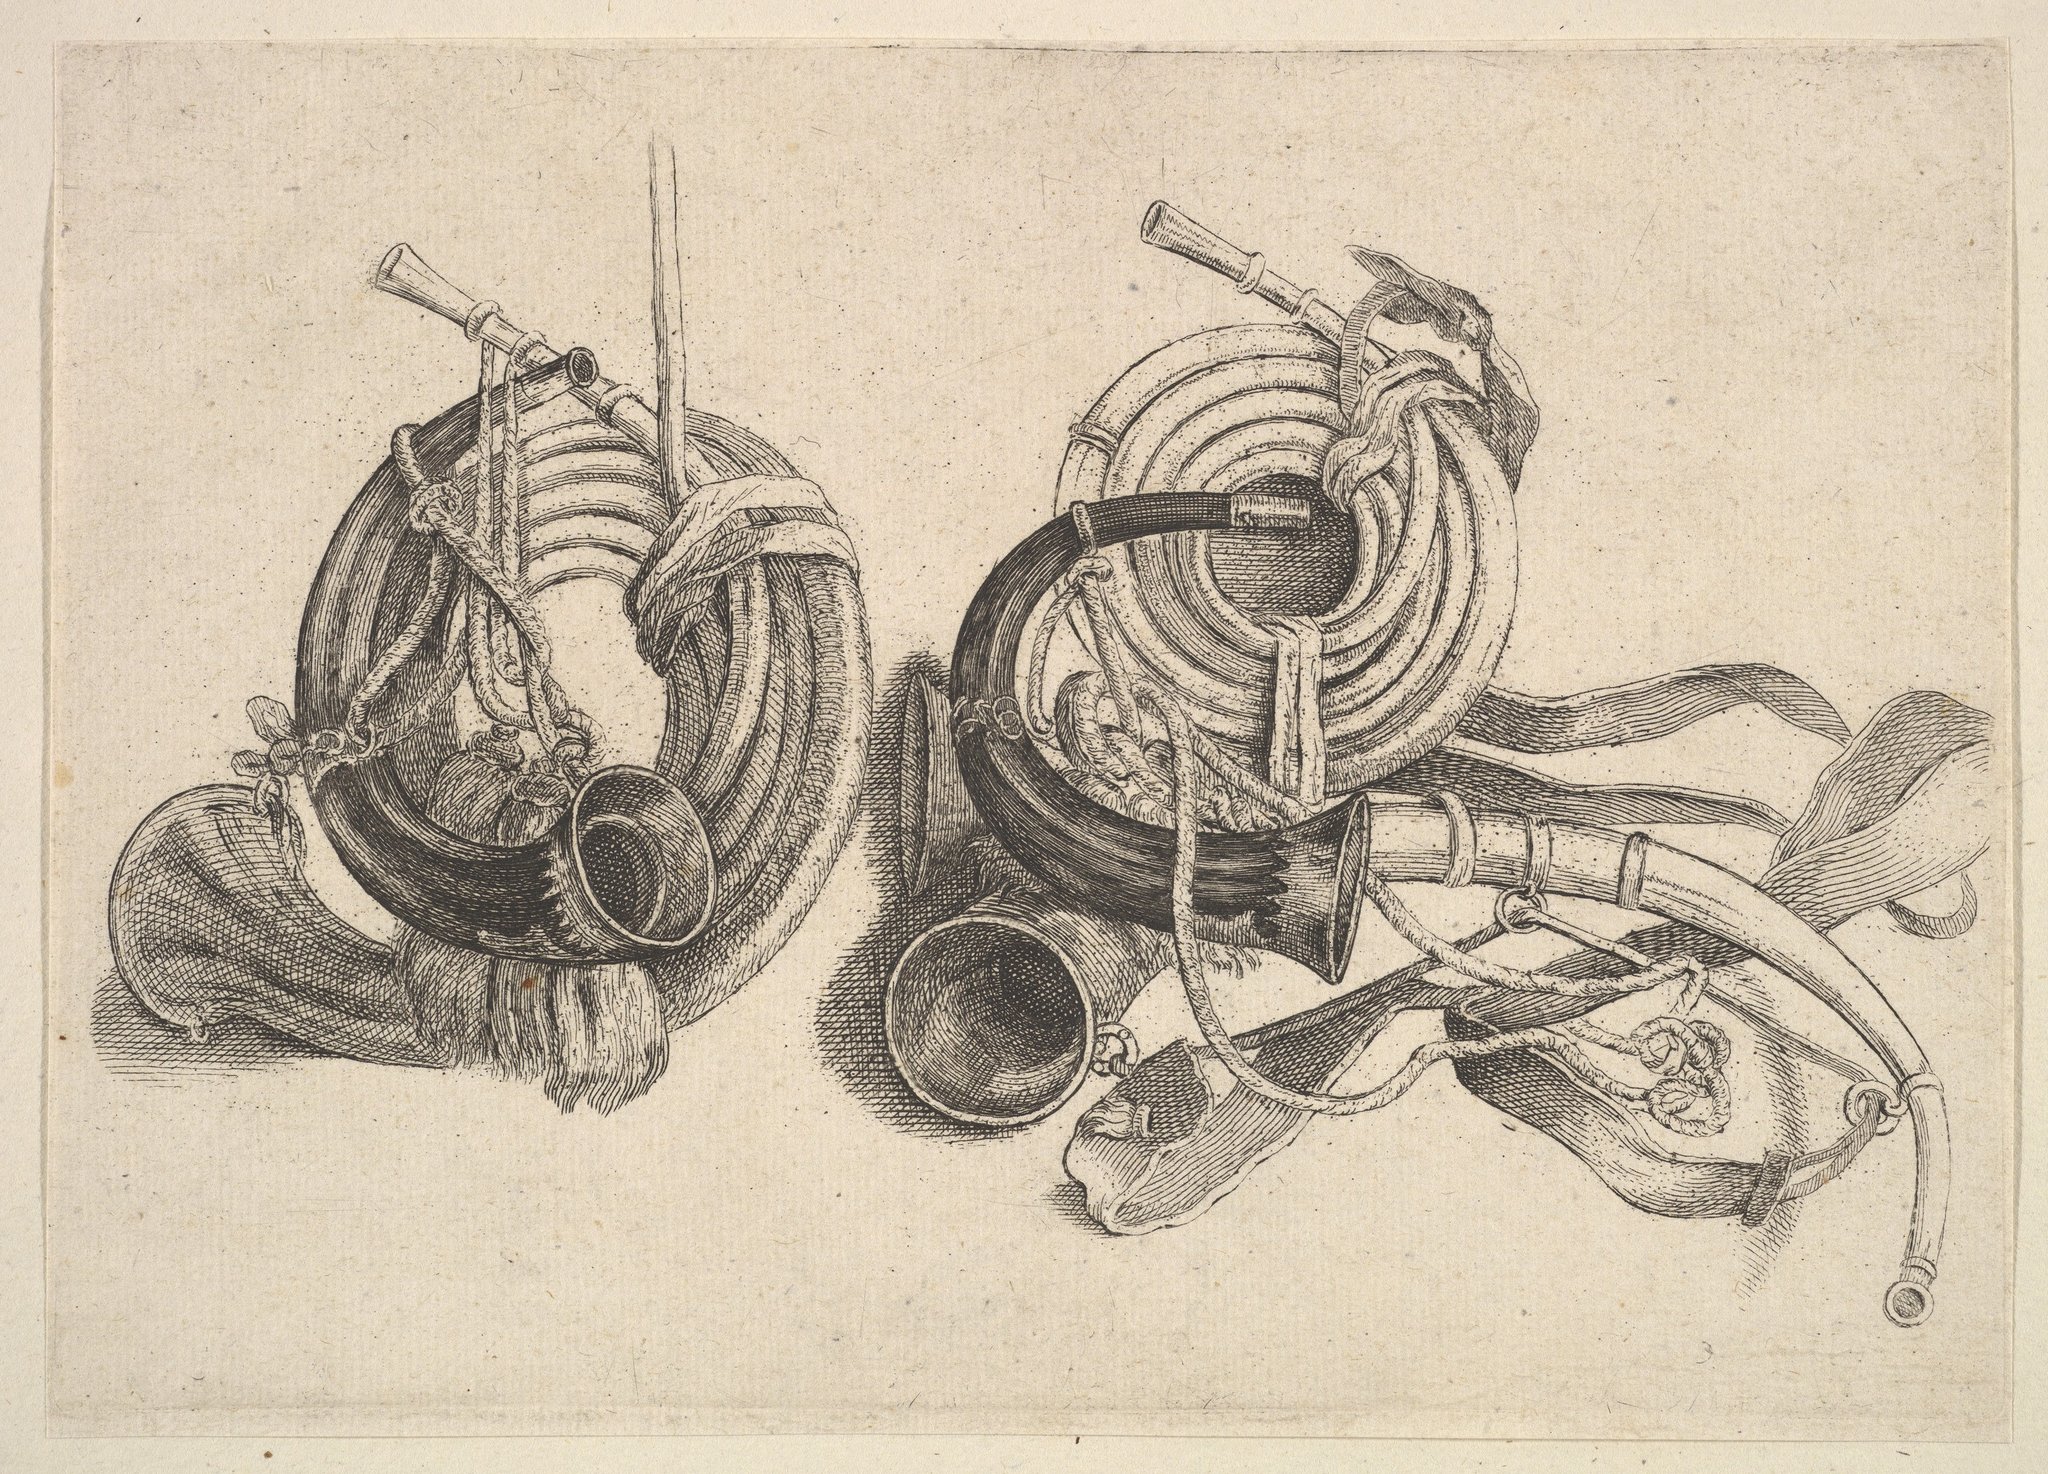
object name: print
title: Five hunting horns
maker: wenceslaus hollar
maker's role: artist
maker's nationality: bohemian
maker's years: 1607-1677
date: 1647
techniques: etching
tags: horns